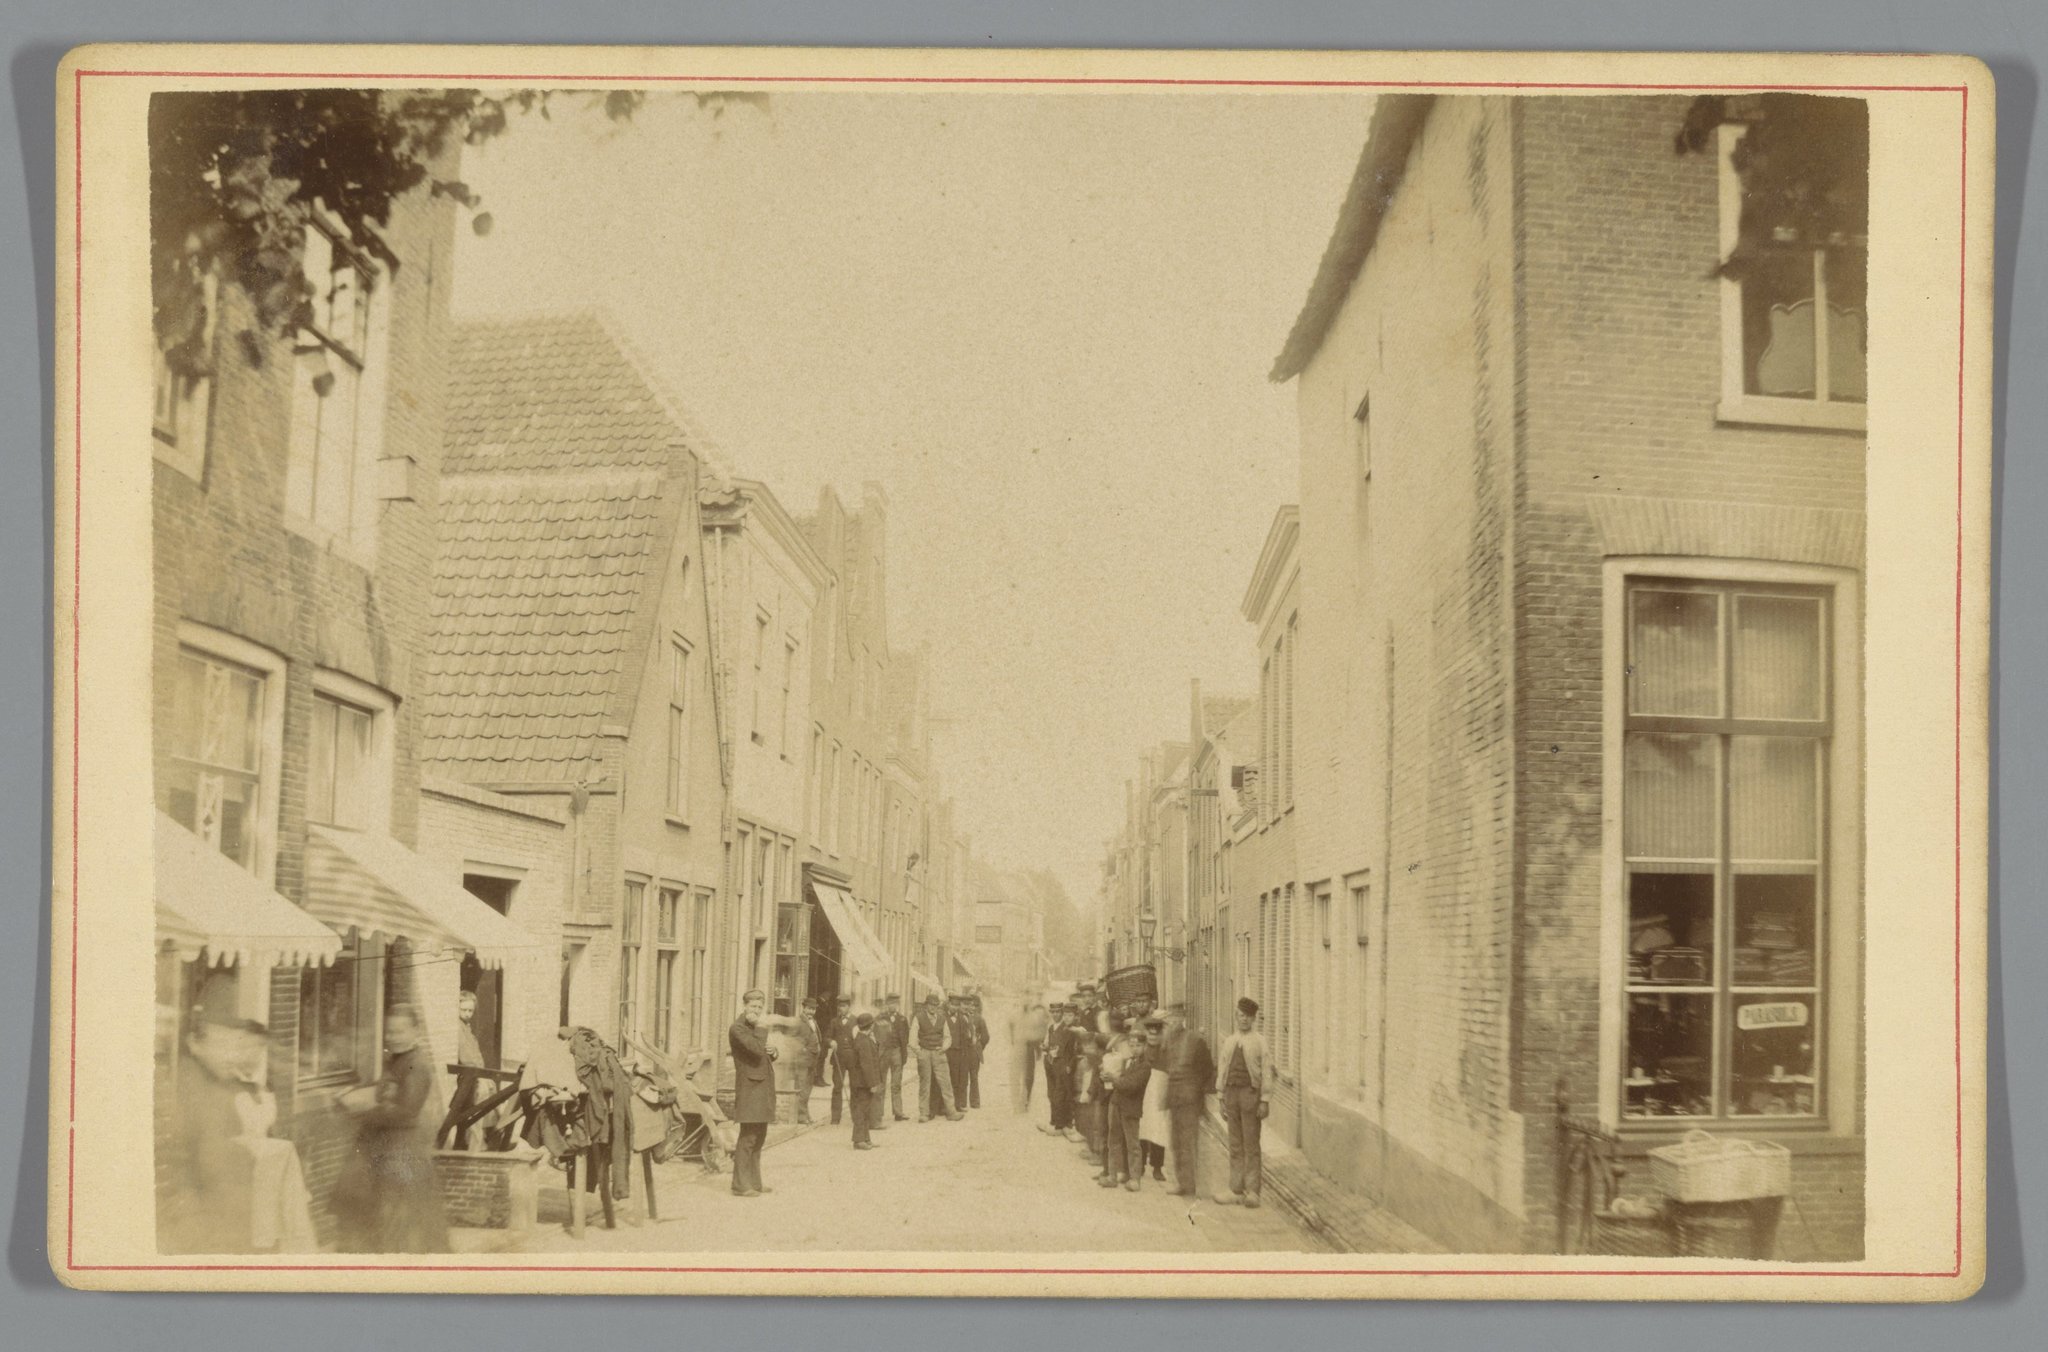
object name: cabinet photograph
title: Lopikerstraat te Schoonhoven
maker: lodewijk hendrikus serré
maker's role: fotograaf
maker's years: 1847-1897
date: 1882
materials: cardboard, paper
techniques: albumen print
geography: schoonhoven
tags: street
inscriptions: inscription: ‘L H Serré Utrecht’, stamp: ‘S. & W. N. van Nooten/ Boekhandel/ Schoonhoven’, collector's mark: ‘Vosmaer’